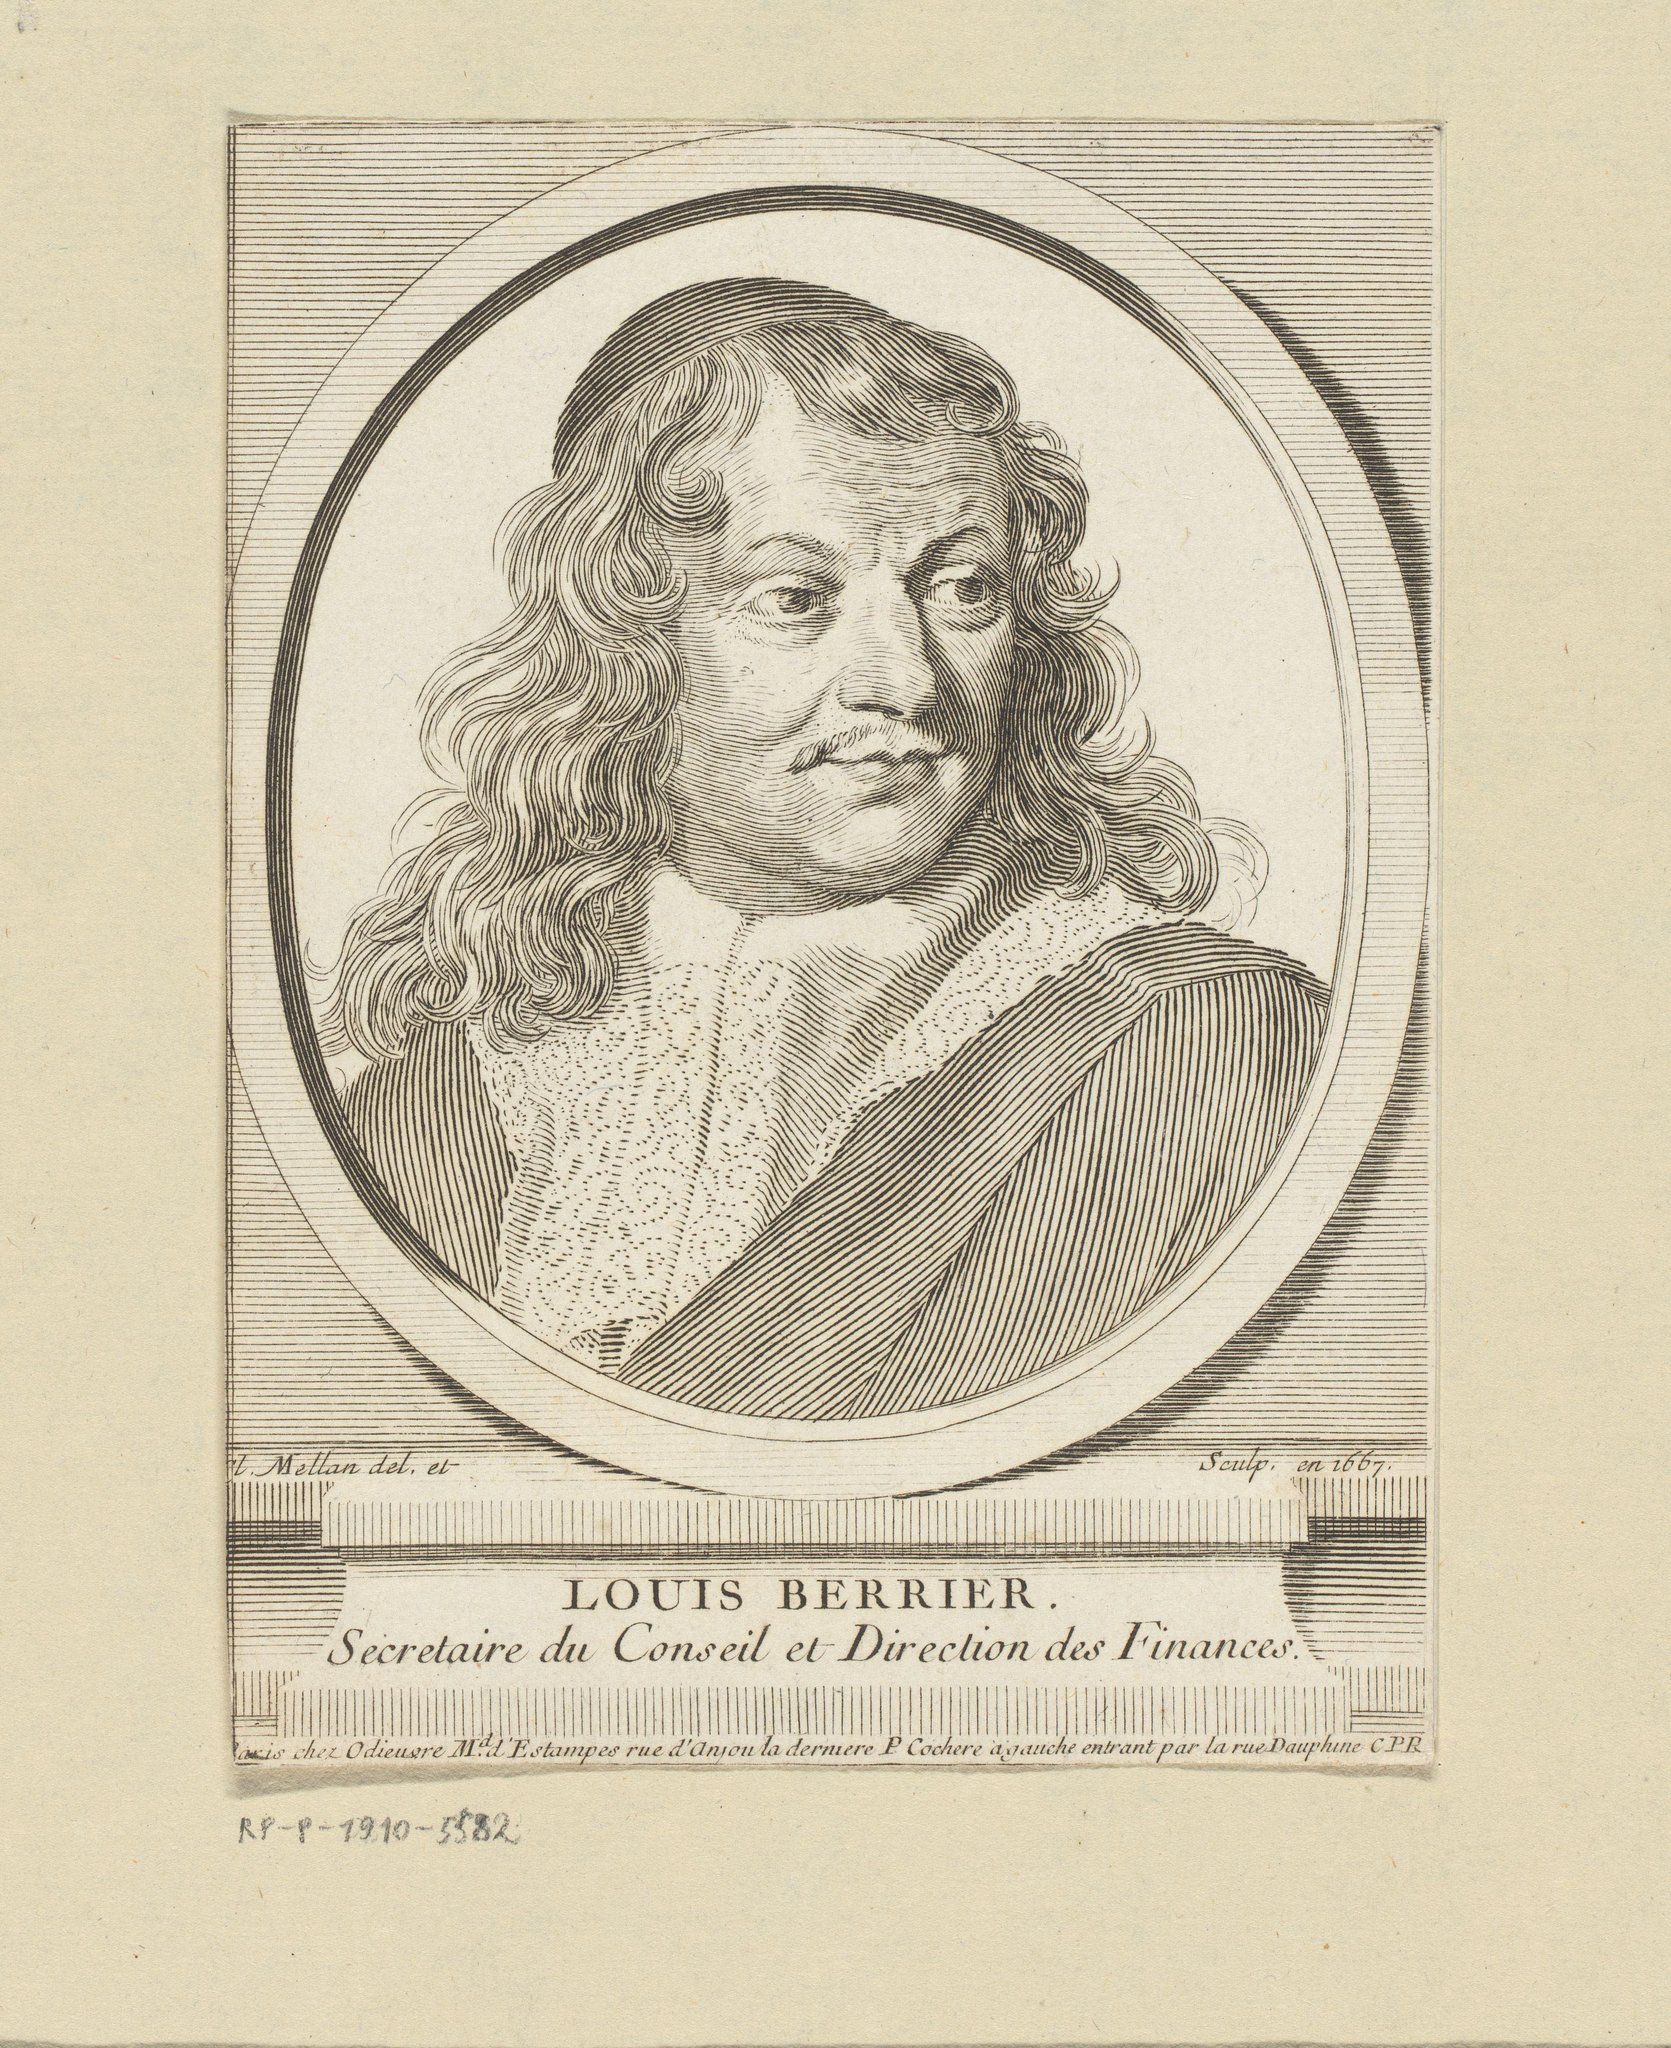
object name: book illustration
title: Portret van Louis Berryer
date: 1667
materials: paper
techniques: engraving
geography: france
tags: historical persons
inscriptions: collector's mark: Lugt 2228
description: Prent uit: Dreux du Radier, Jean-François. L'Europe illustré, contenant l'histoire abregée des souverains, des princes, des prélats, des ministres, (...) en Europe: dans le XVe. siècle compris, jusqu'à présent. Parijs: Michel Odieuvre en Jean-Luc Nyon, 1755-1765, dl. 5.